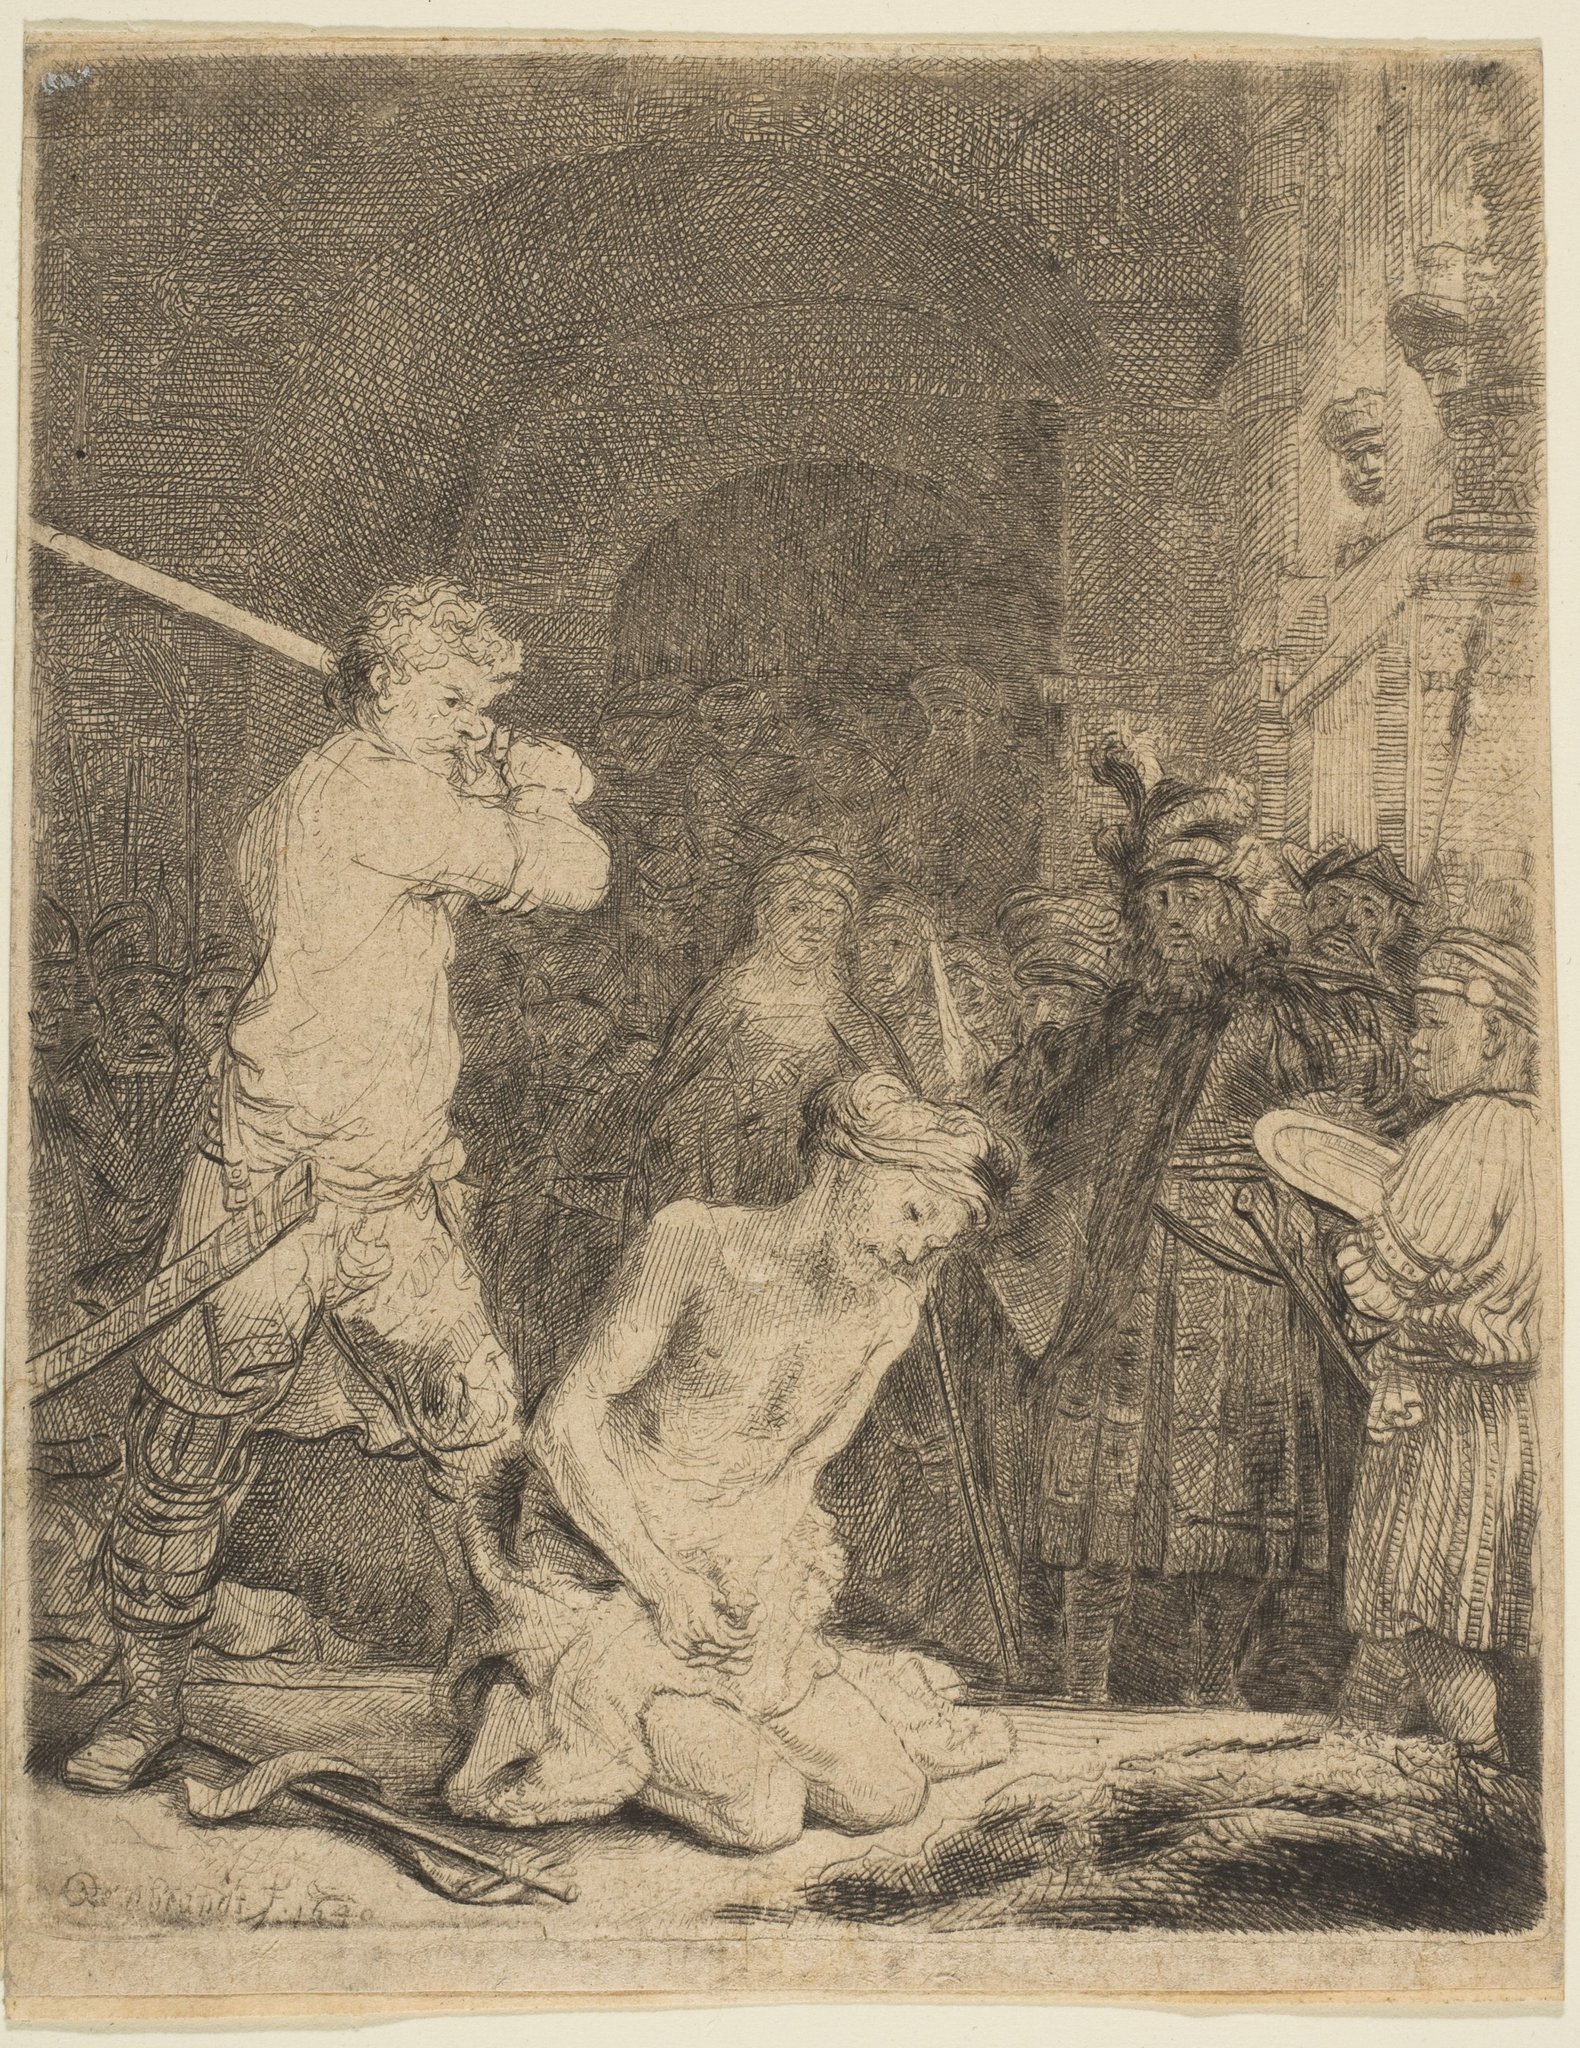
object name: print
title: The Beheading of John the Baptist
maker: rembrandt van rijn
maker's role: artist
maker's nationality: dutch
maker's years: 1606-1669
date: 1634-1644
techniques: drypoint, etching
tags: swords,men,saint john the baptist